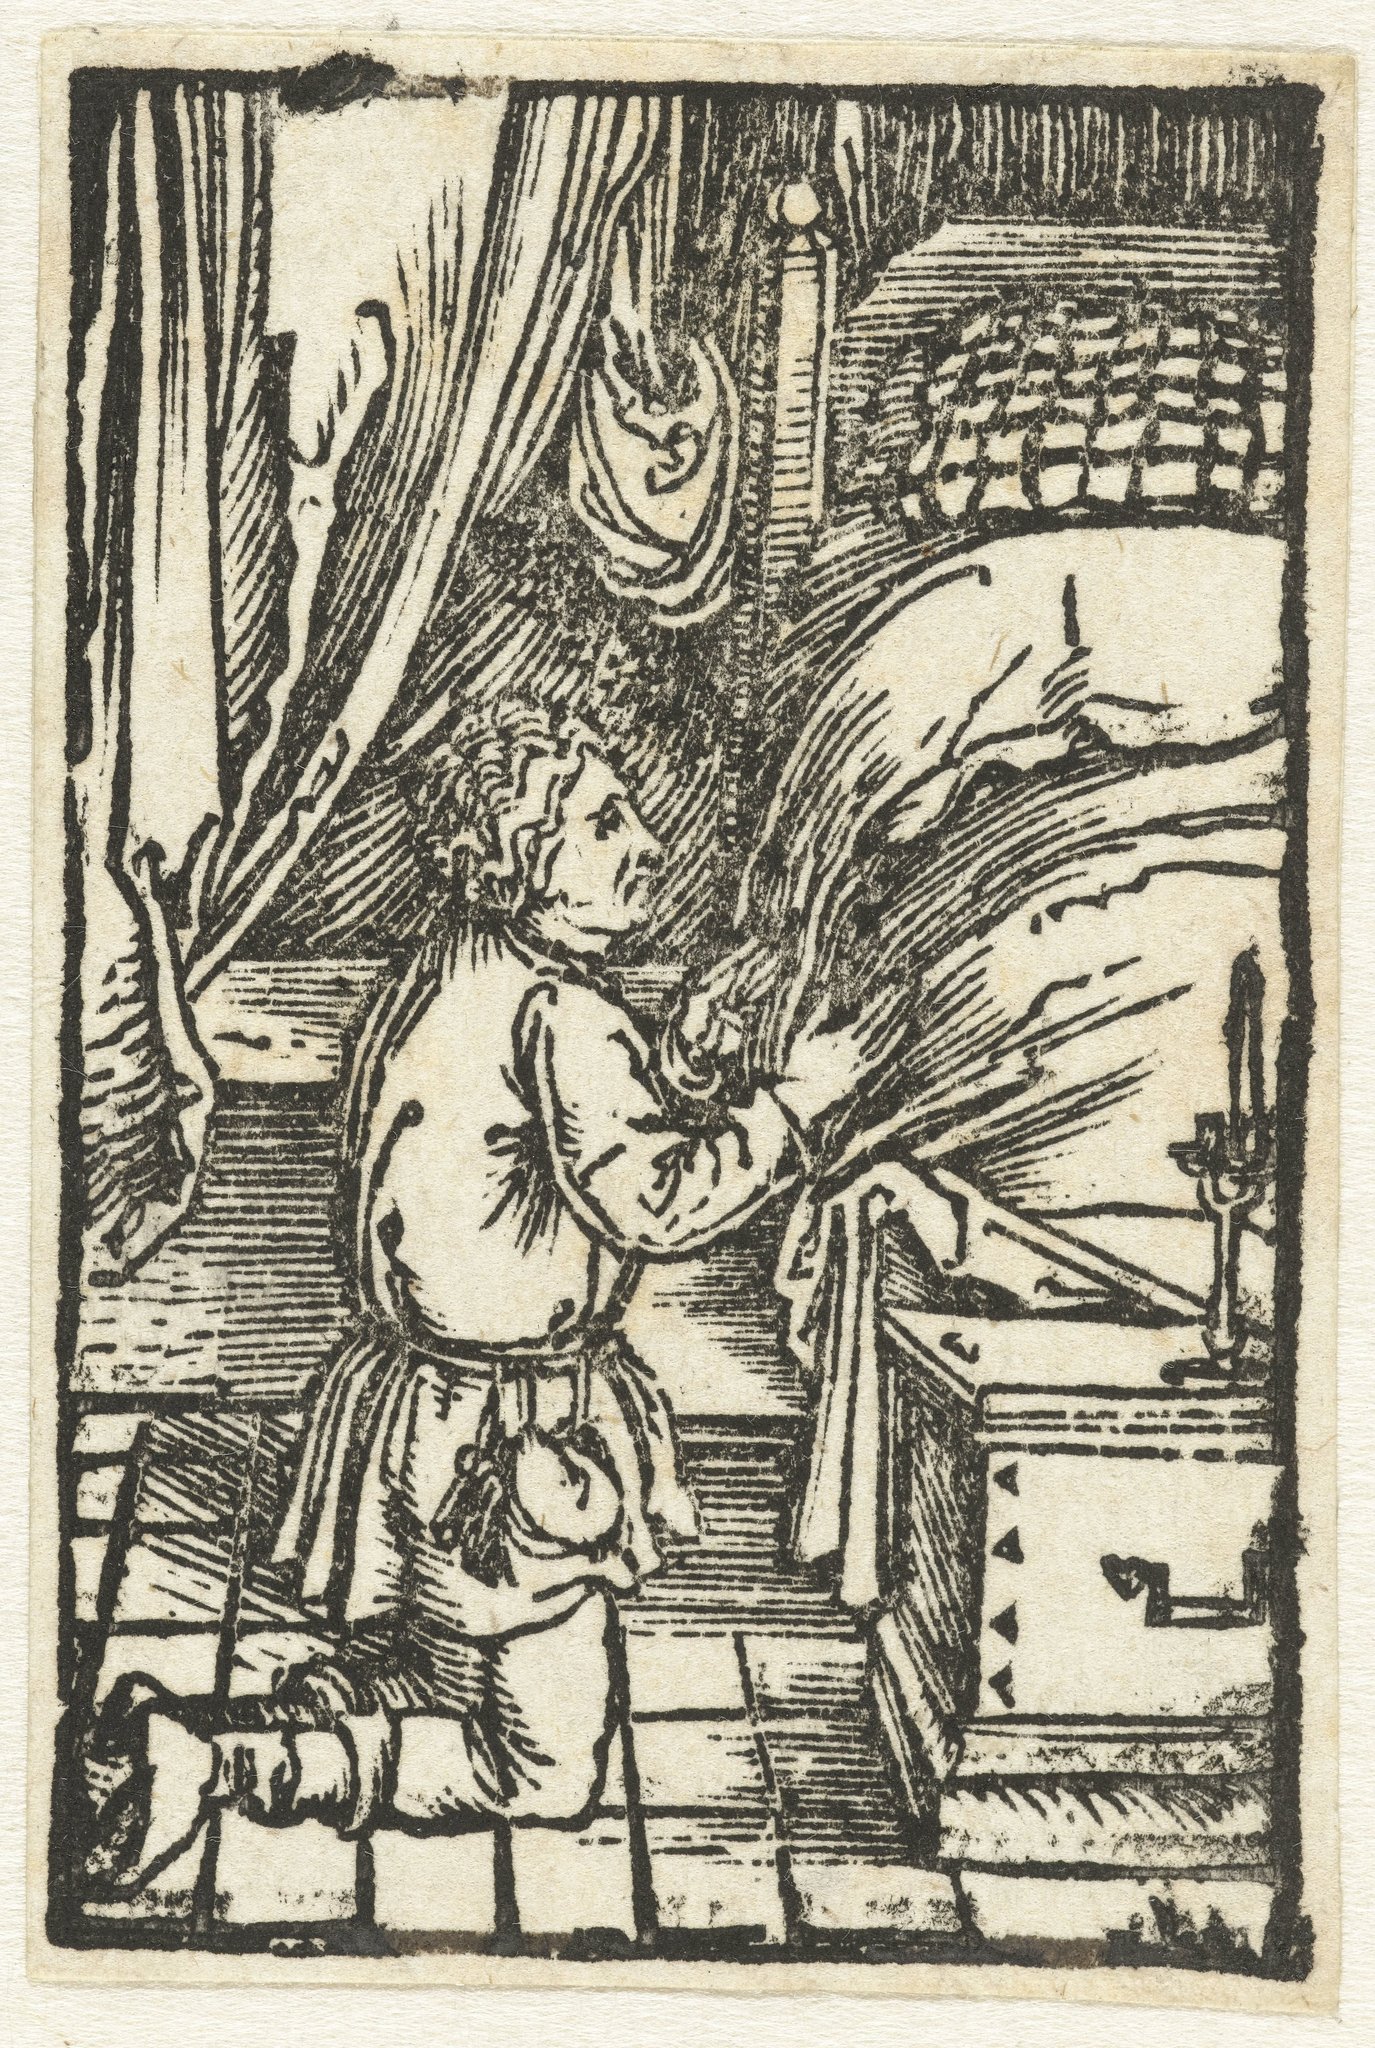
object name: book illustration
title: Avondgebed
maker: albrecht dürer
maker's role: draughtsman, painter, print maker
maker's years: 1471-1528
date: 1503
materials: paper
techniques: woodcut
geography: nuremberg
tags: prayer at going to bed, or at getting up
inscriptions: collector's mark: Lugt 240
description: Illustratie voor: Salus anim[a]e, Neurenberg: Hieronymus Höltzel, 1503. Klinkert, C.